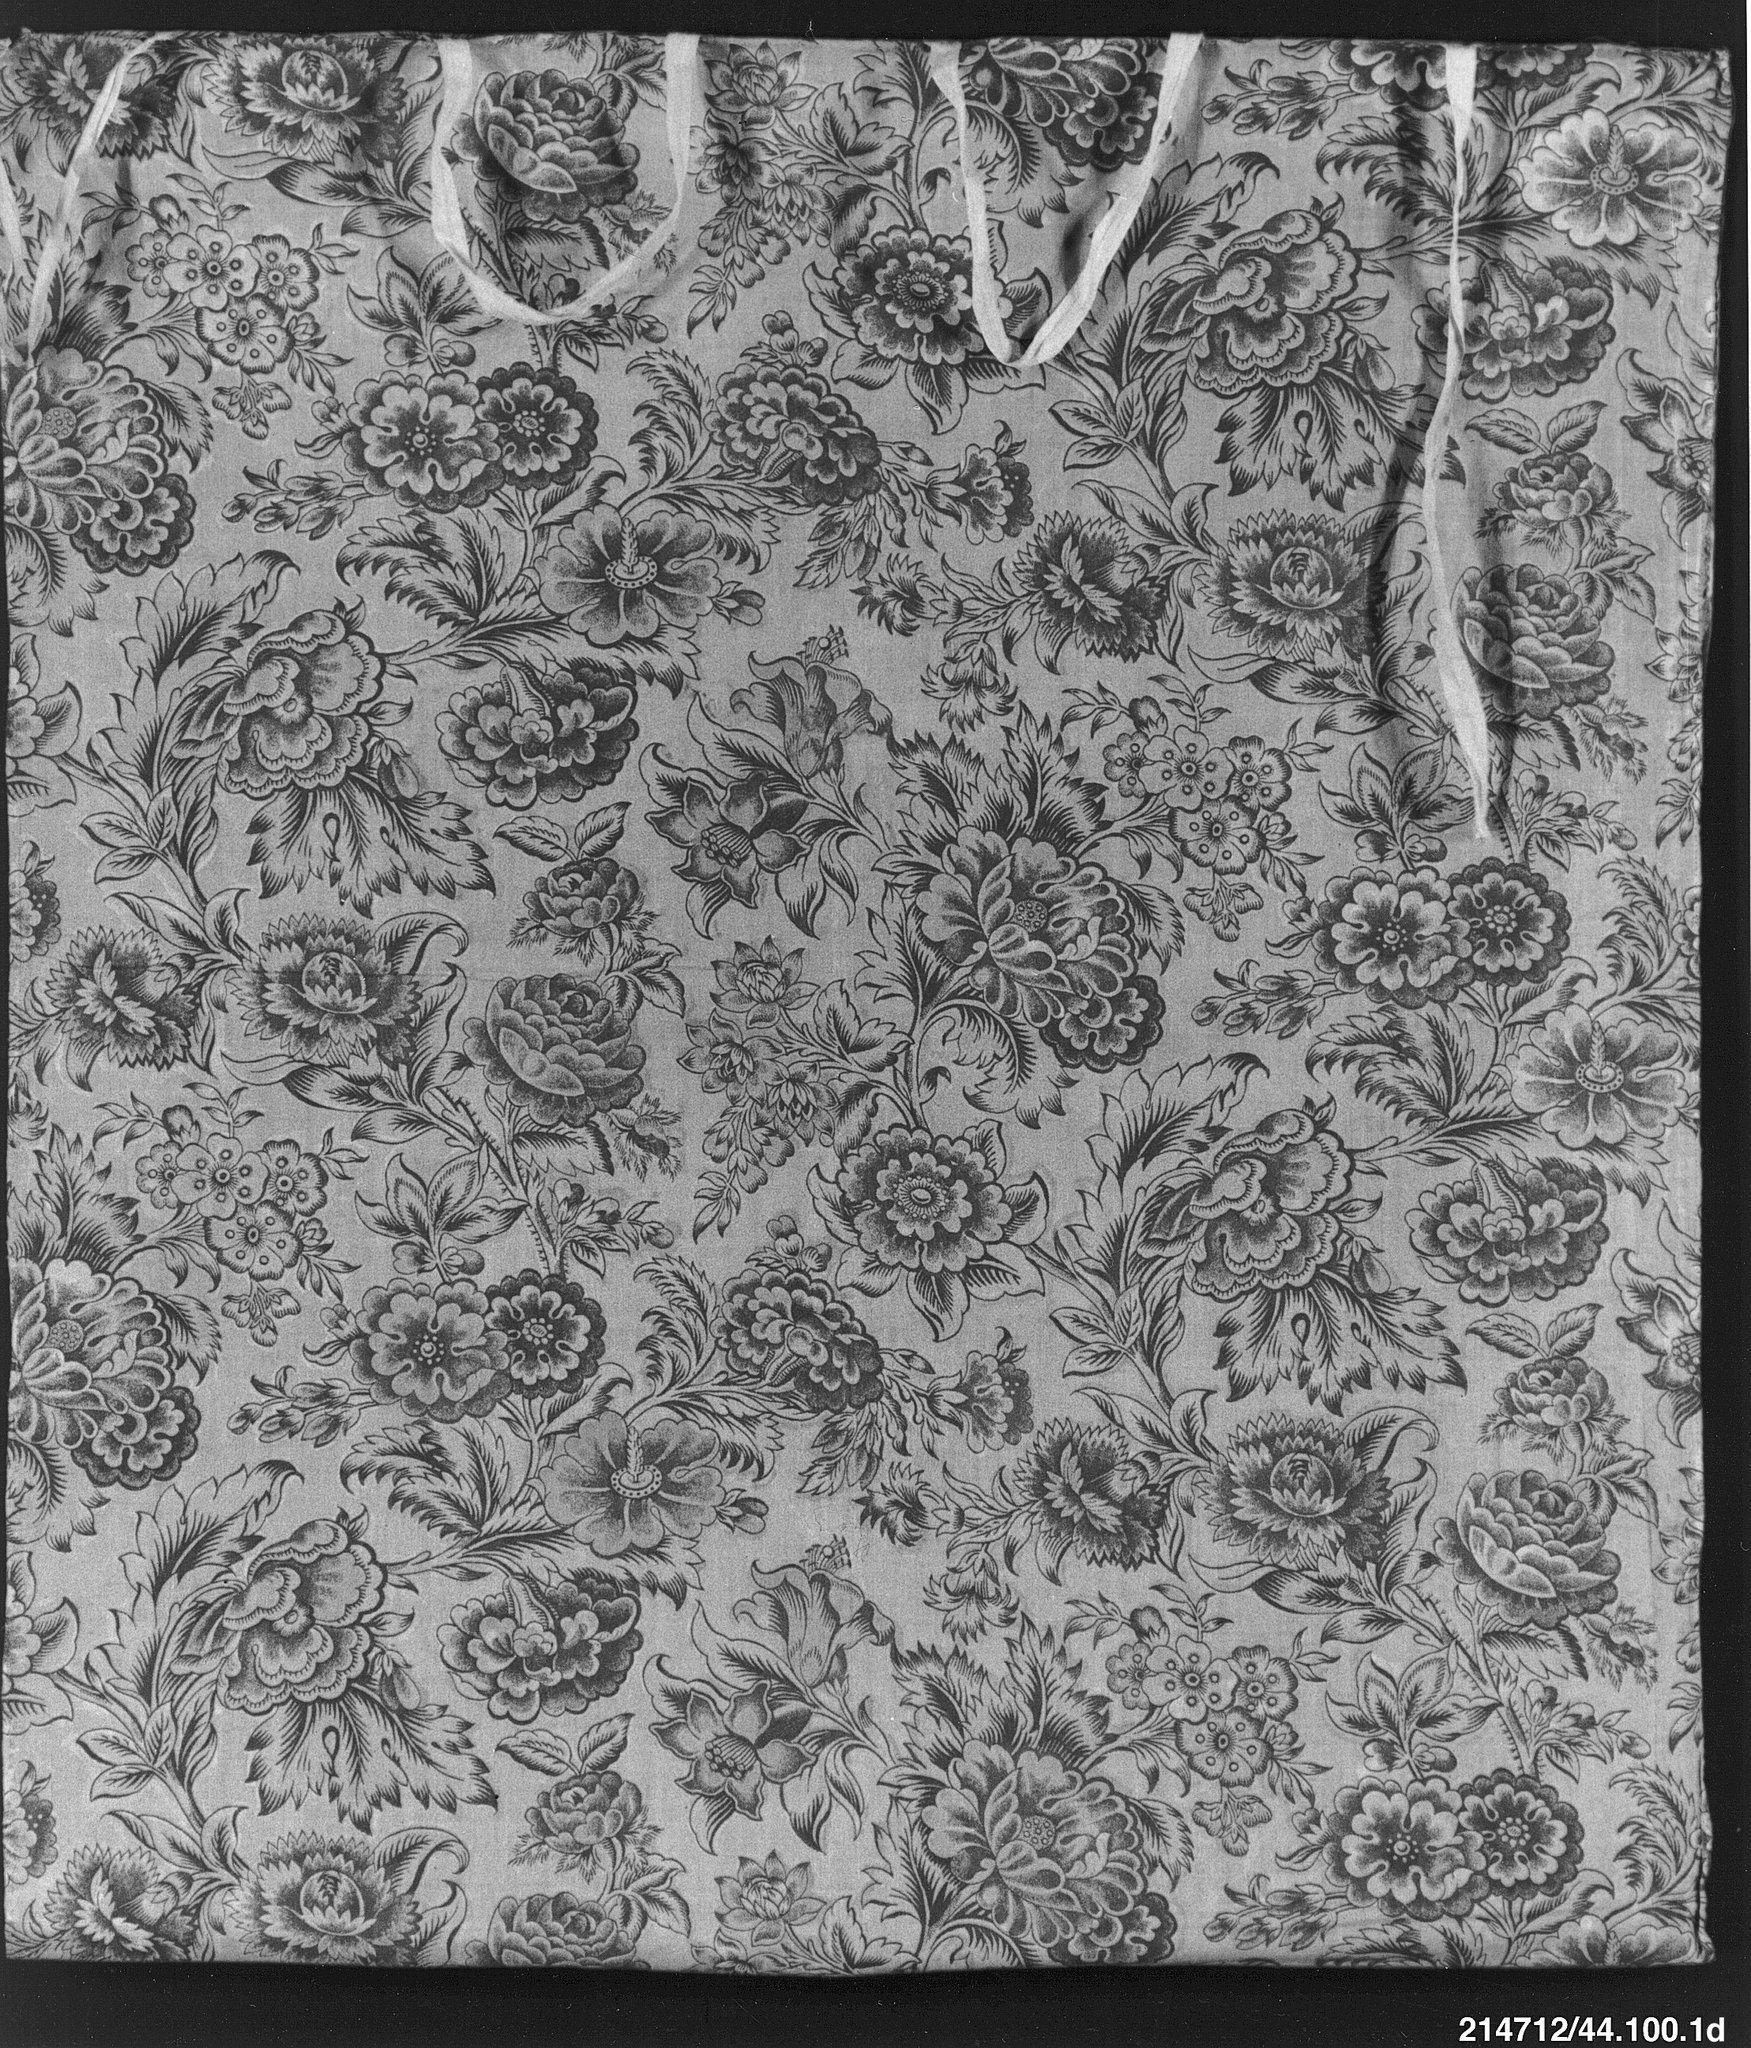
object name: width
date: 1820-1830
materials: cotton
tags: flowers